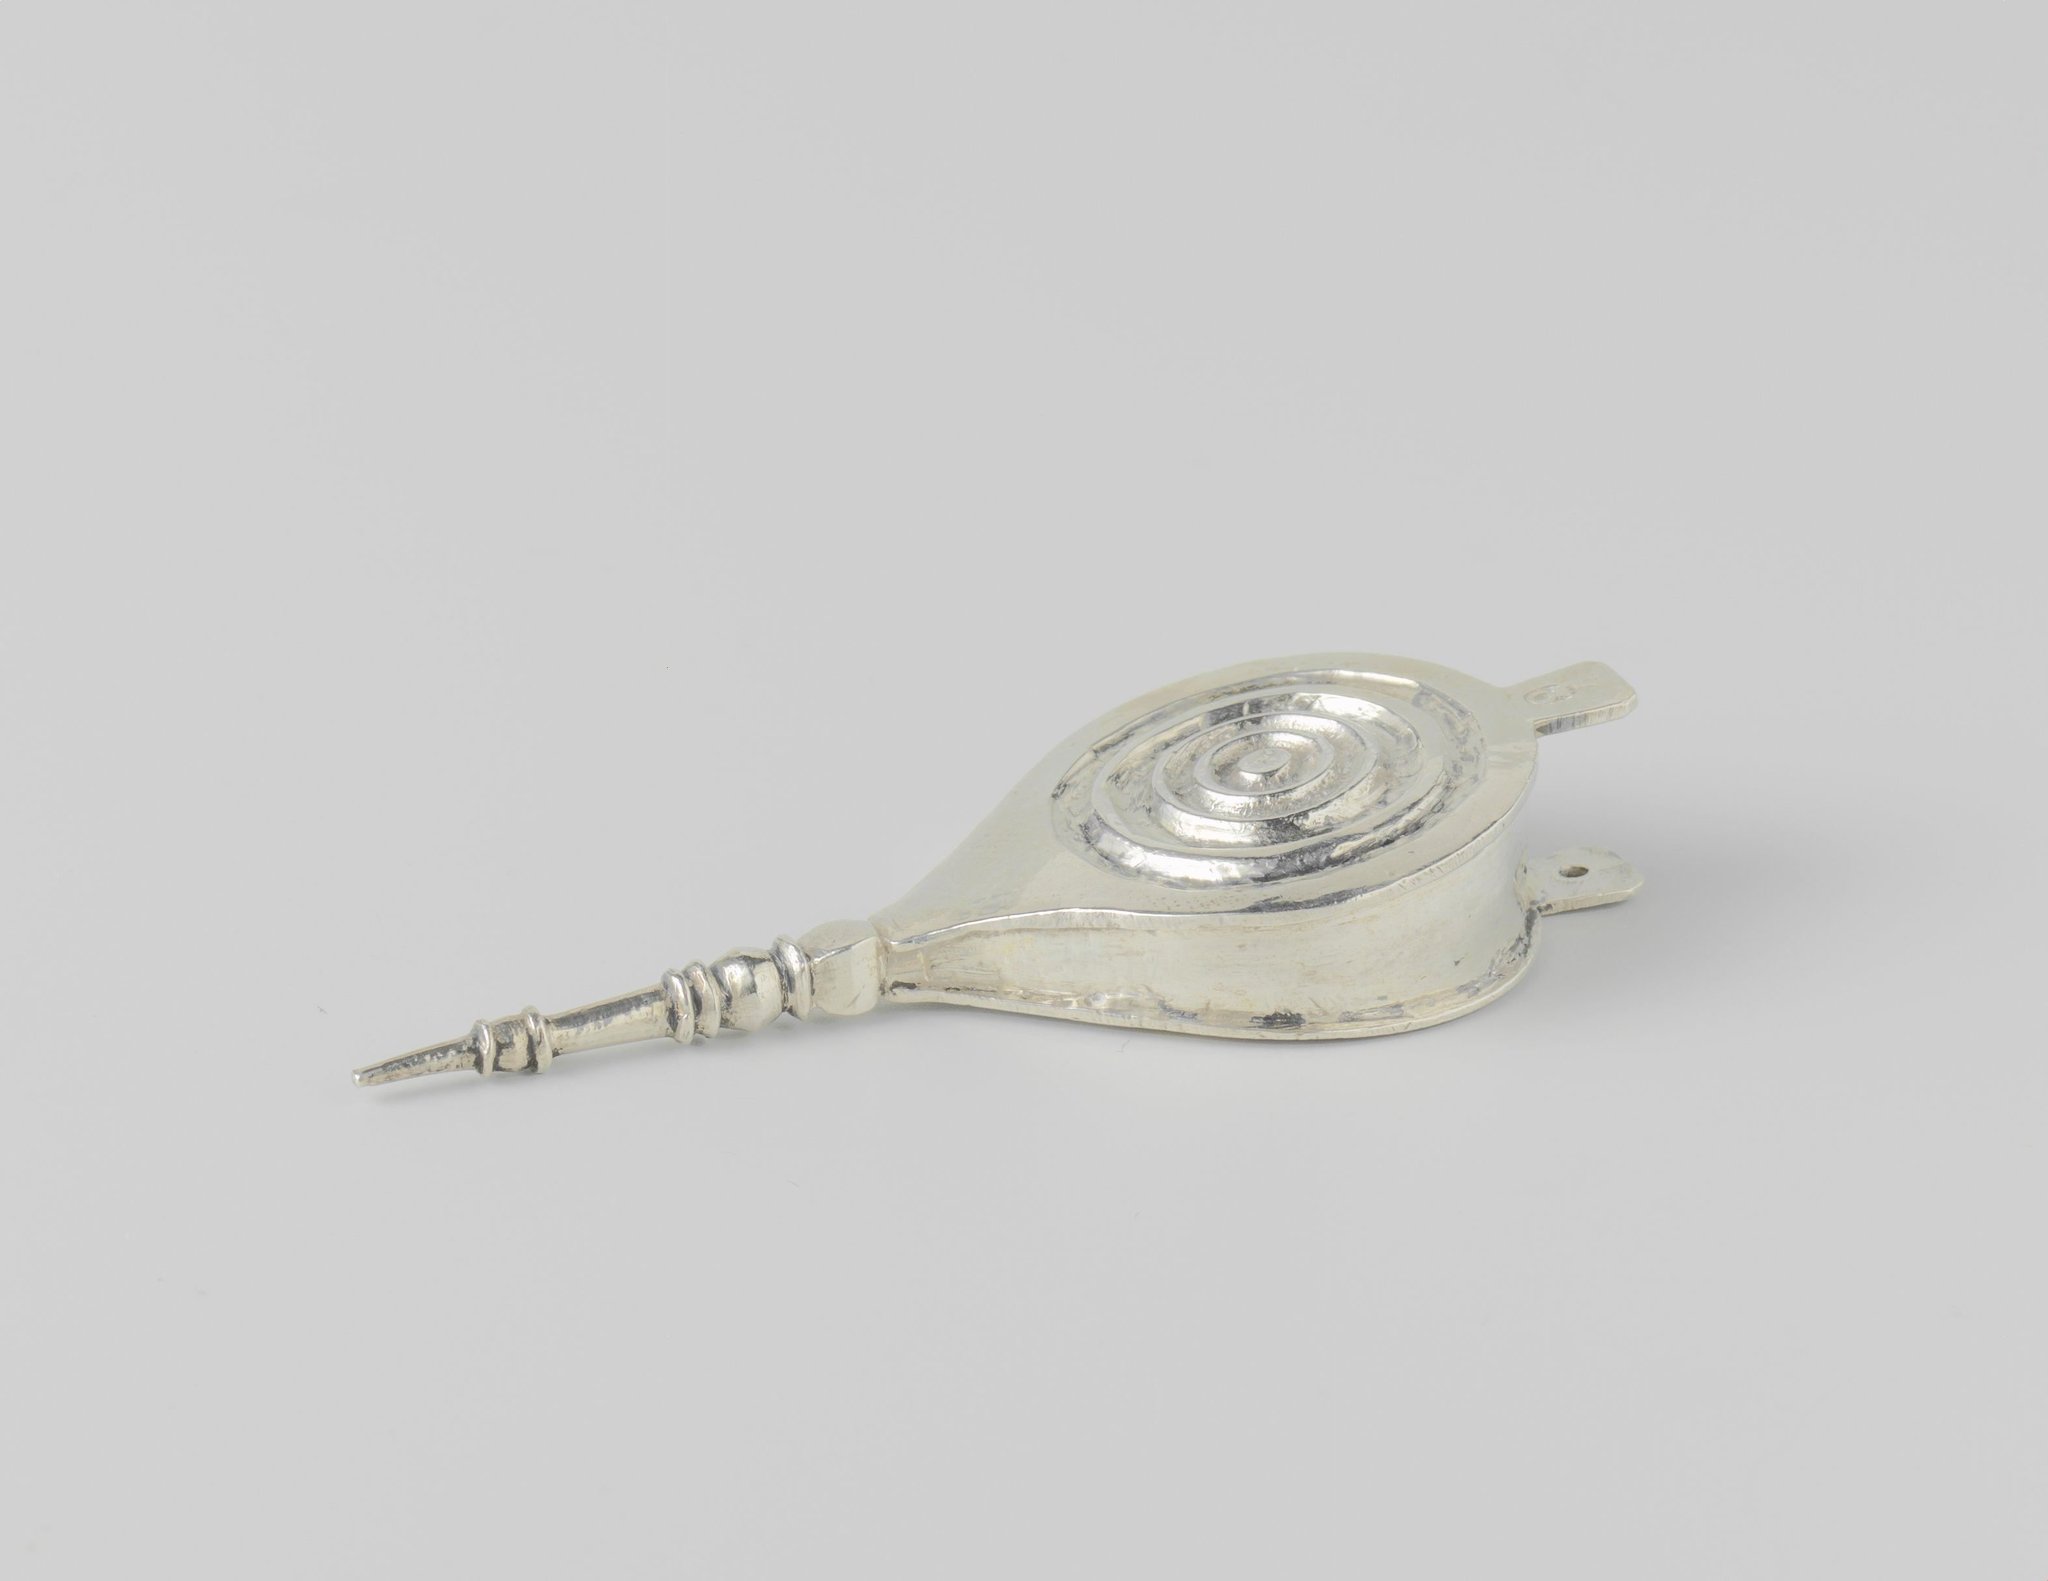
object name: miniature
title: Blaasbalg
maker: johannes van somerwil (i)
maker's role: silversmith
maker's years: 1715-1764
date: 1761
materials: silver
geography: amsterdam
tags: bellows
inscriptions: maker's mark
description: Blaasbalg met een geprofileerd mondstuk en concentrische cirkels op de balg. De onderkant van de blaasbalg is glad, heeft drie gaten en een draagoog. De blaasbalg is gemerkt: stk.= Amsterdam, jrl.= B (1761), mt.= Voet 443, gekroonde O en een bijltje.